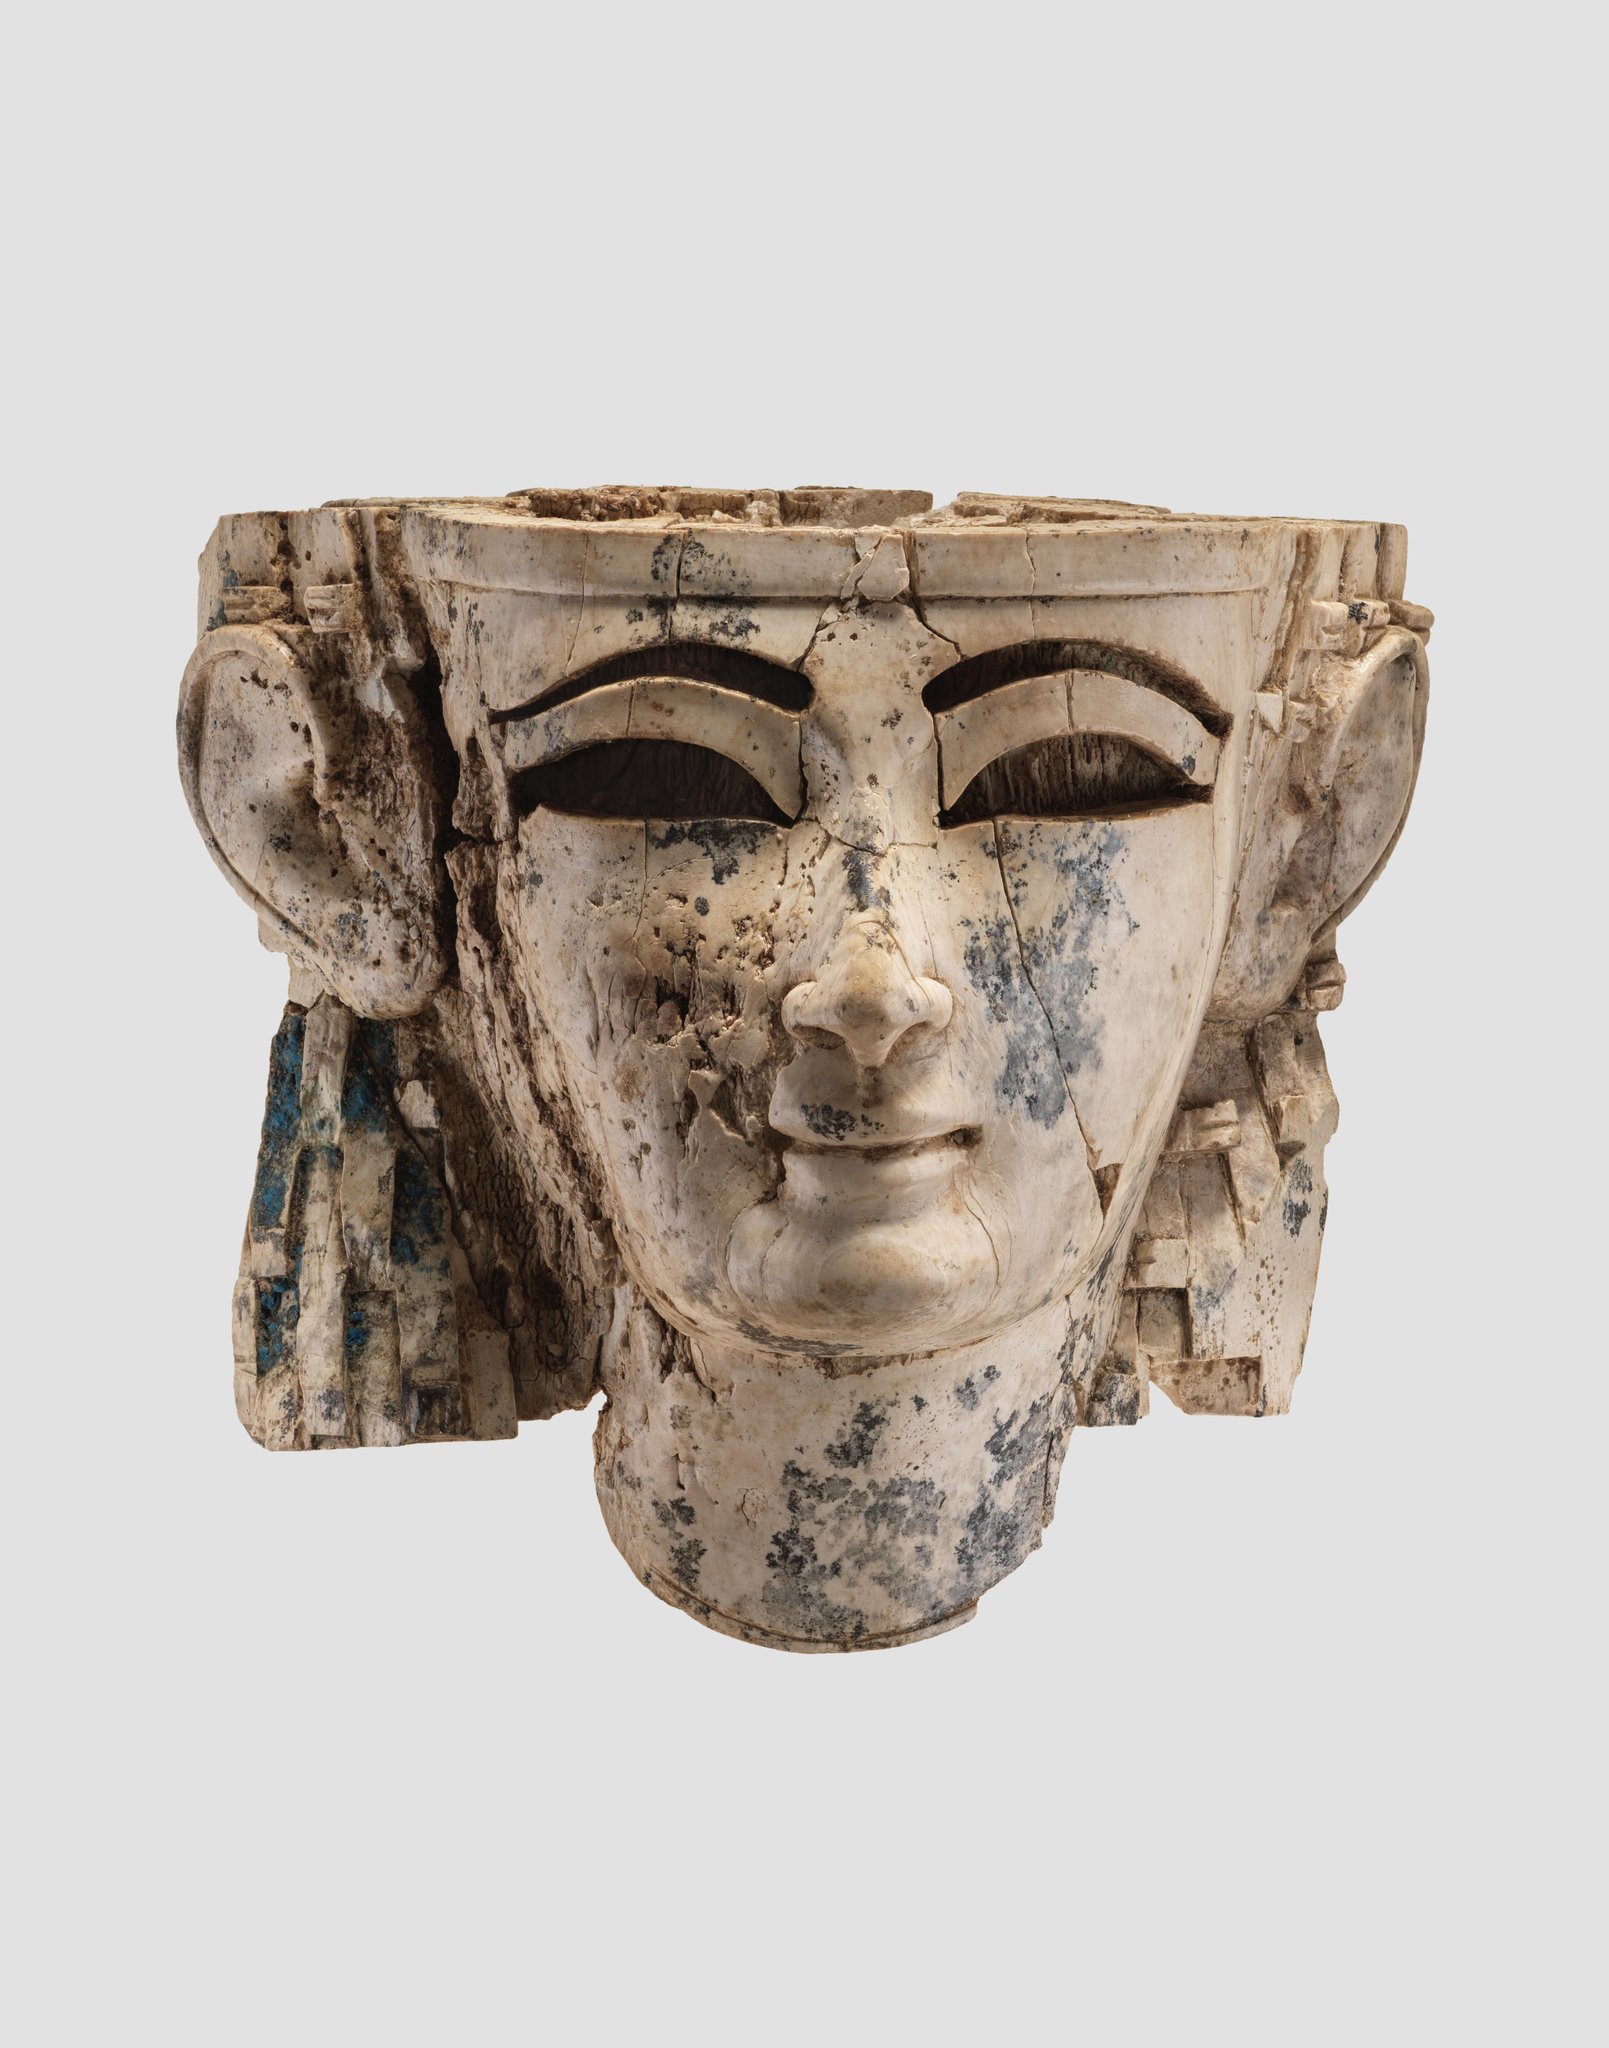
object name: sculpture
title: Head of a male or female figure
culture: assyrian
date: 900-701 BCE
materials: ivory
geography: mesopotamia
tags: heads